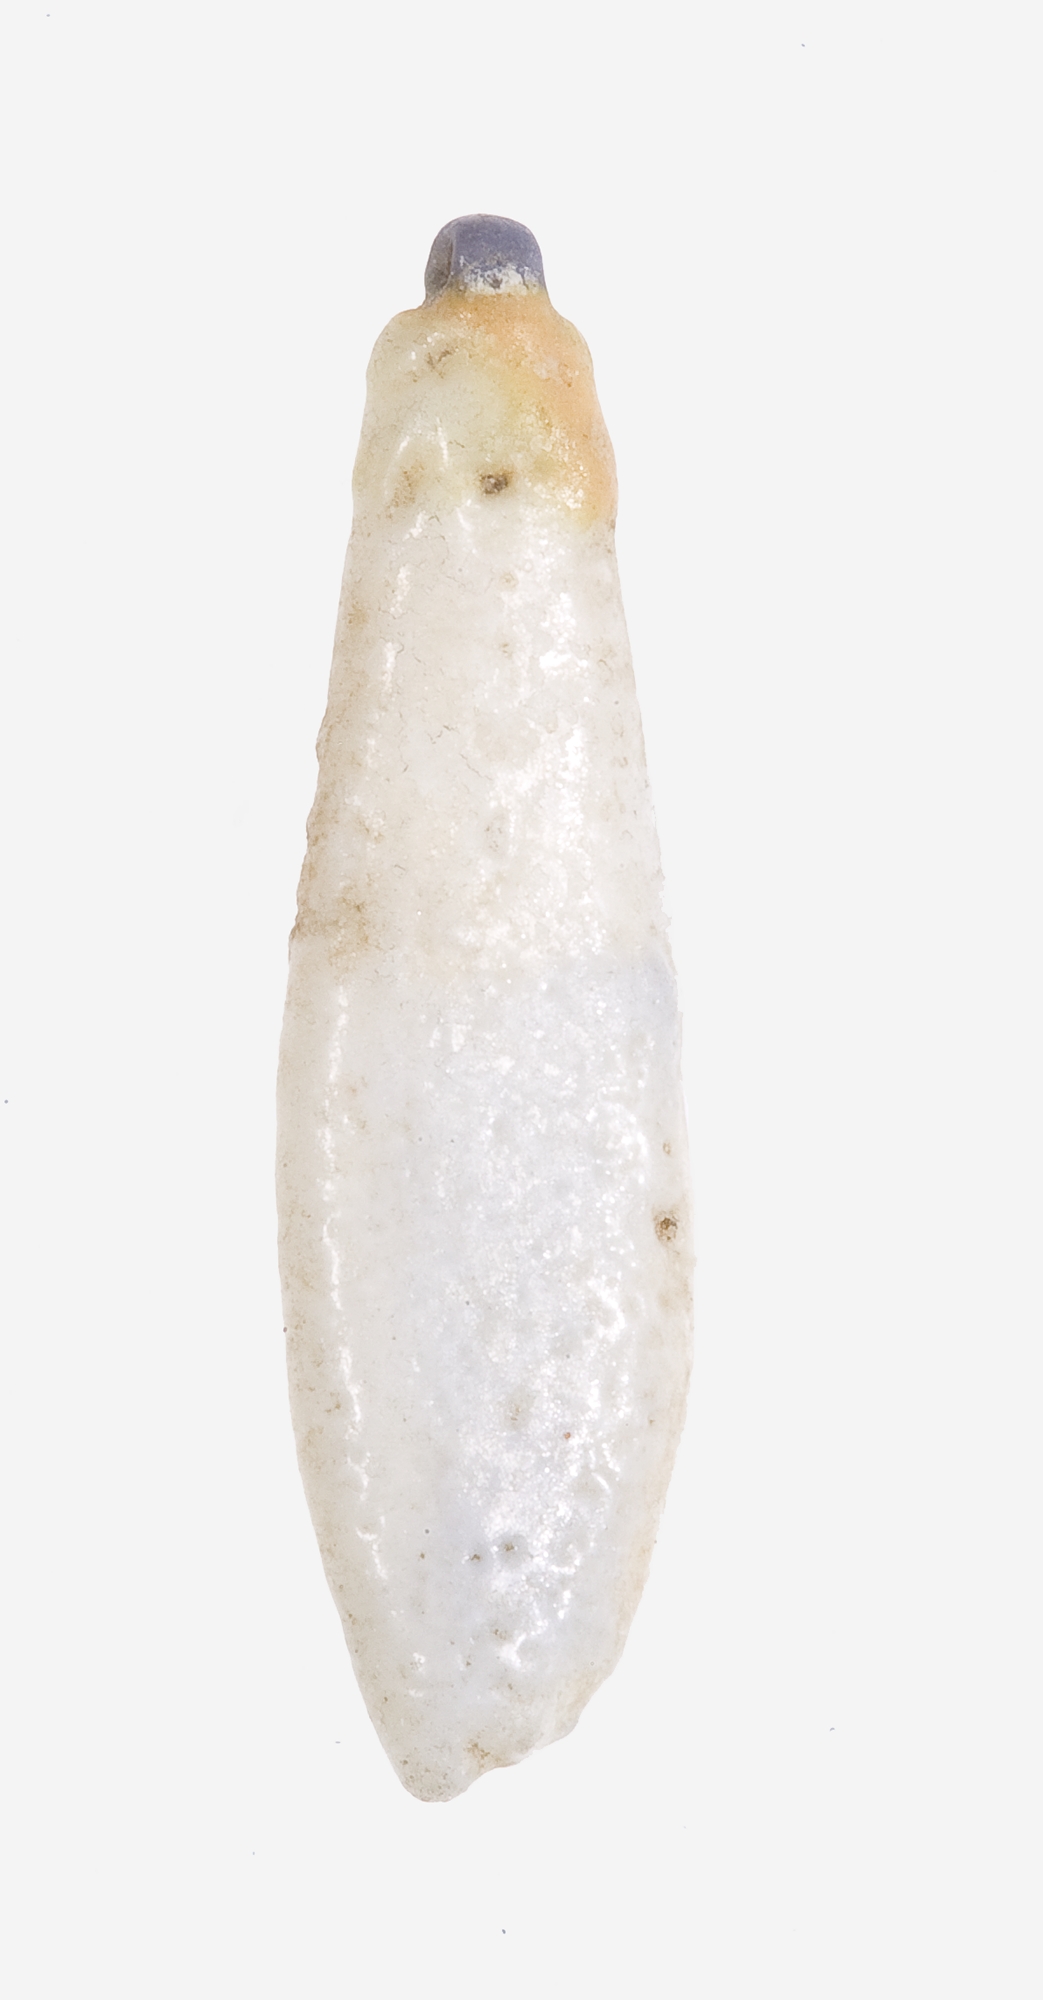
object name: pendant, lotus petal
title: Lotus Petal Pendant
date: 1390-1352 BCE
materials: faience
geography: egypt